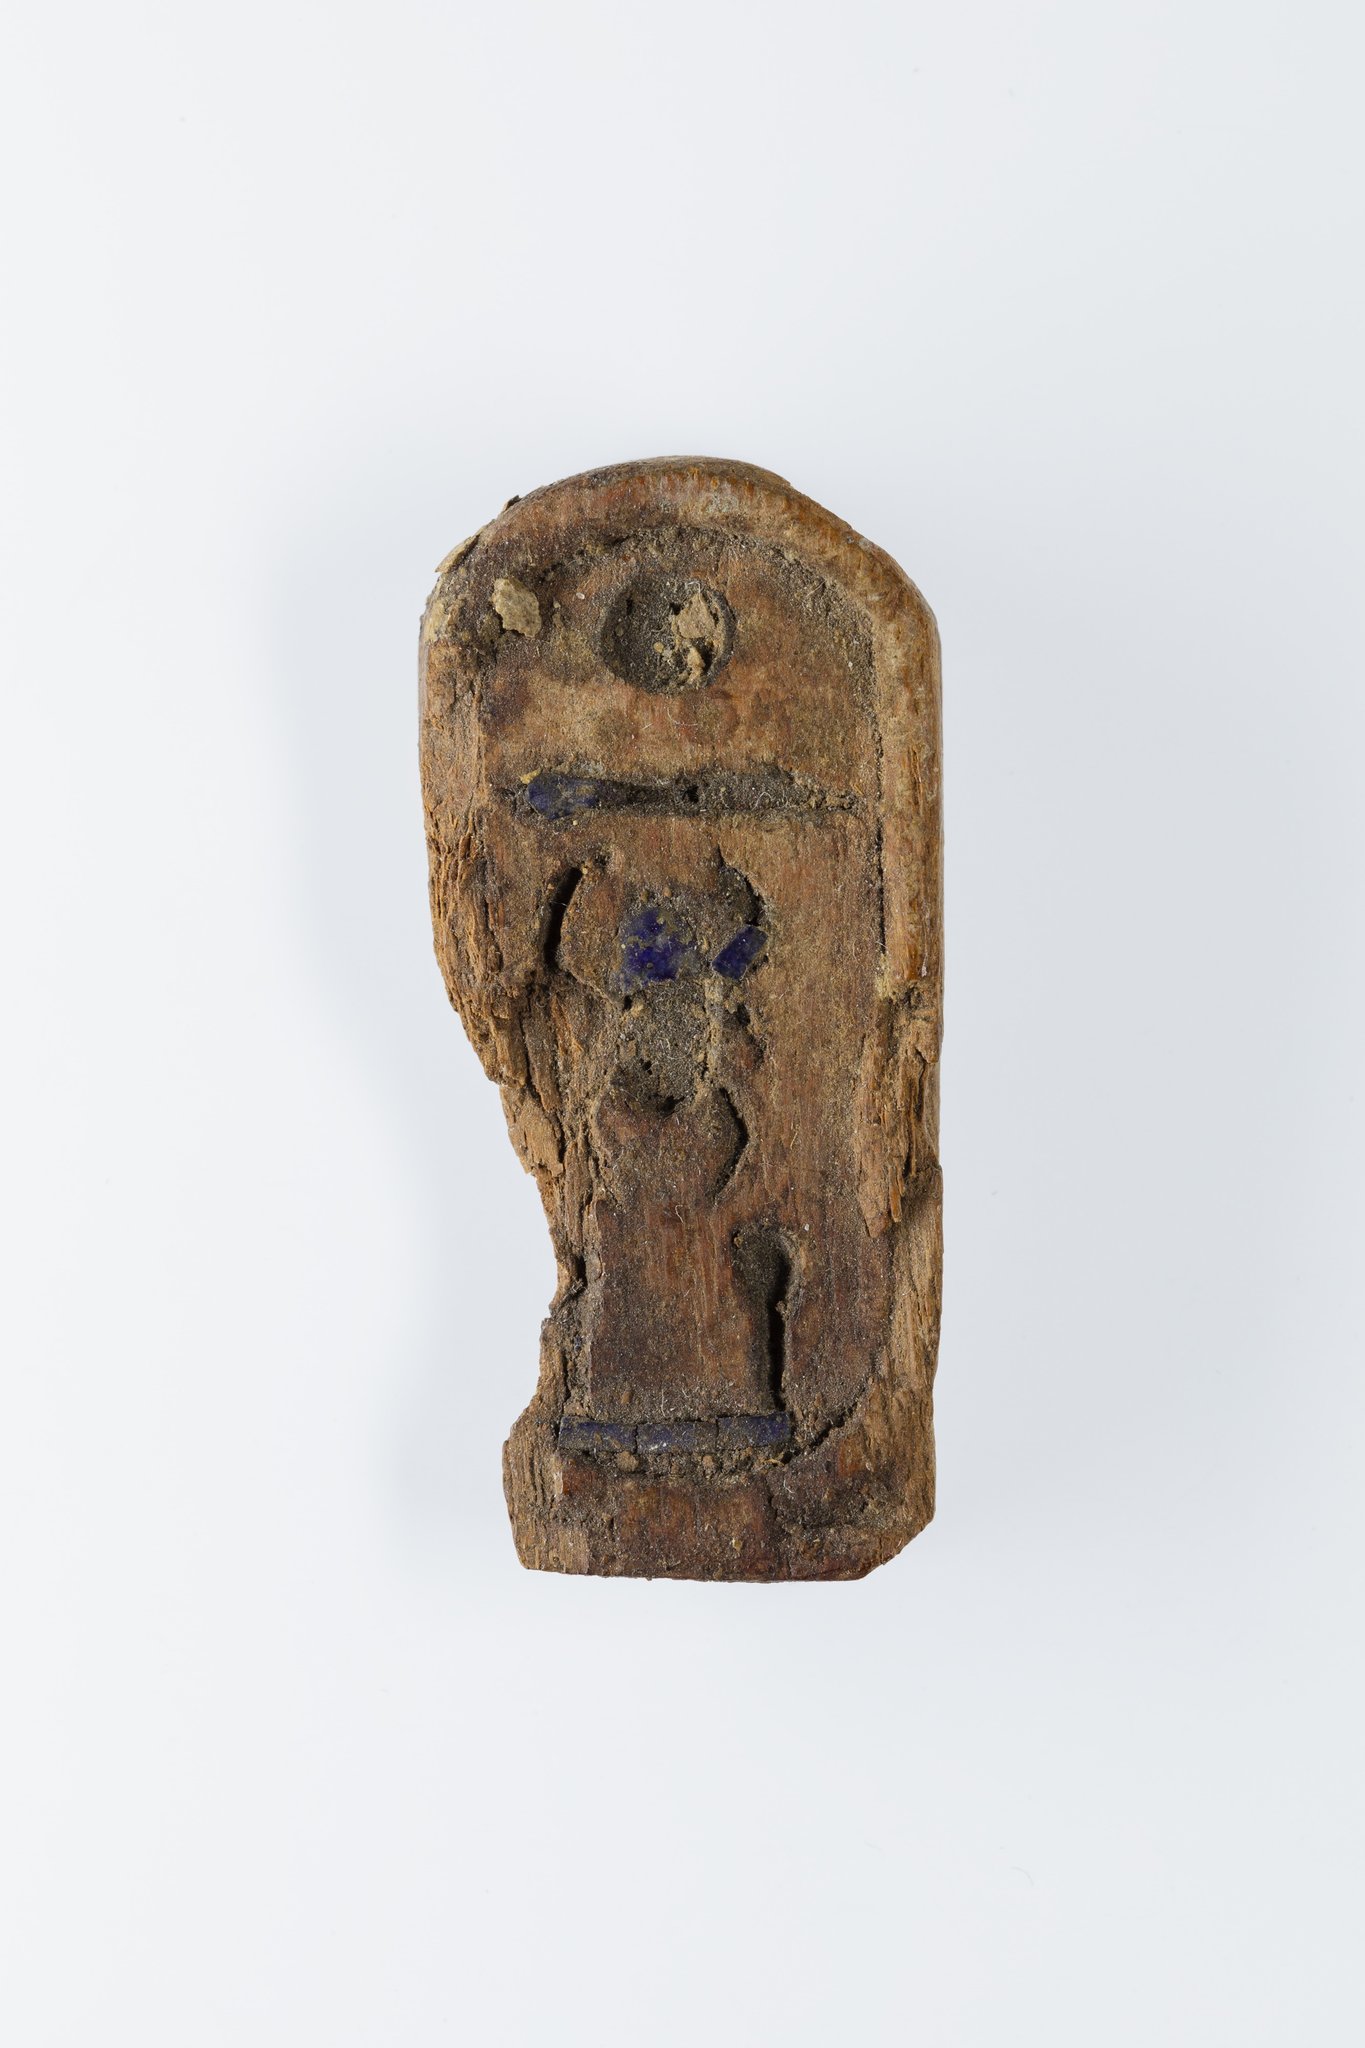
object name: inlay, cartouche, thutmose i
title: Cartouche-Shaped Inlay with the Name of Thutmose I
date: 1550-1295 BCE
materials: wood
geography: egypt